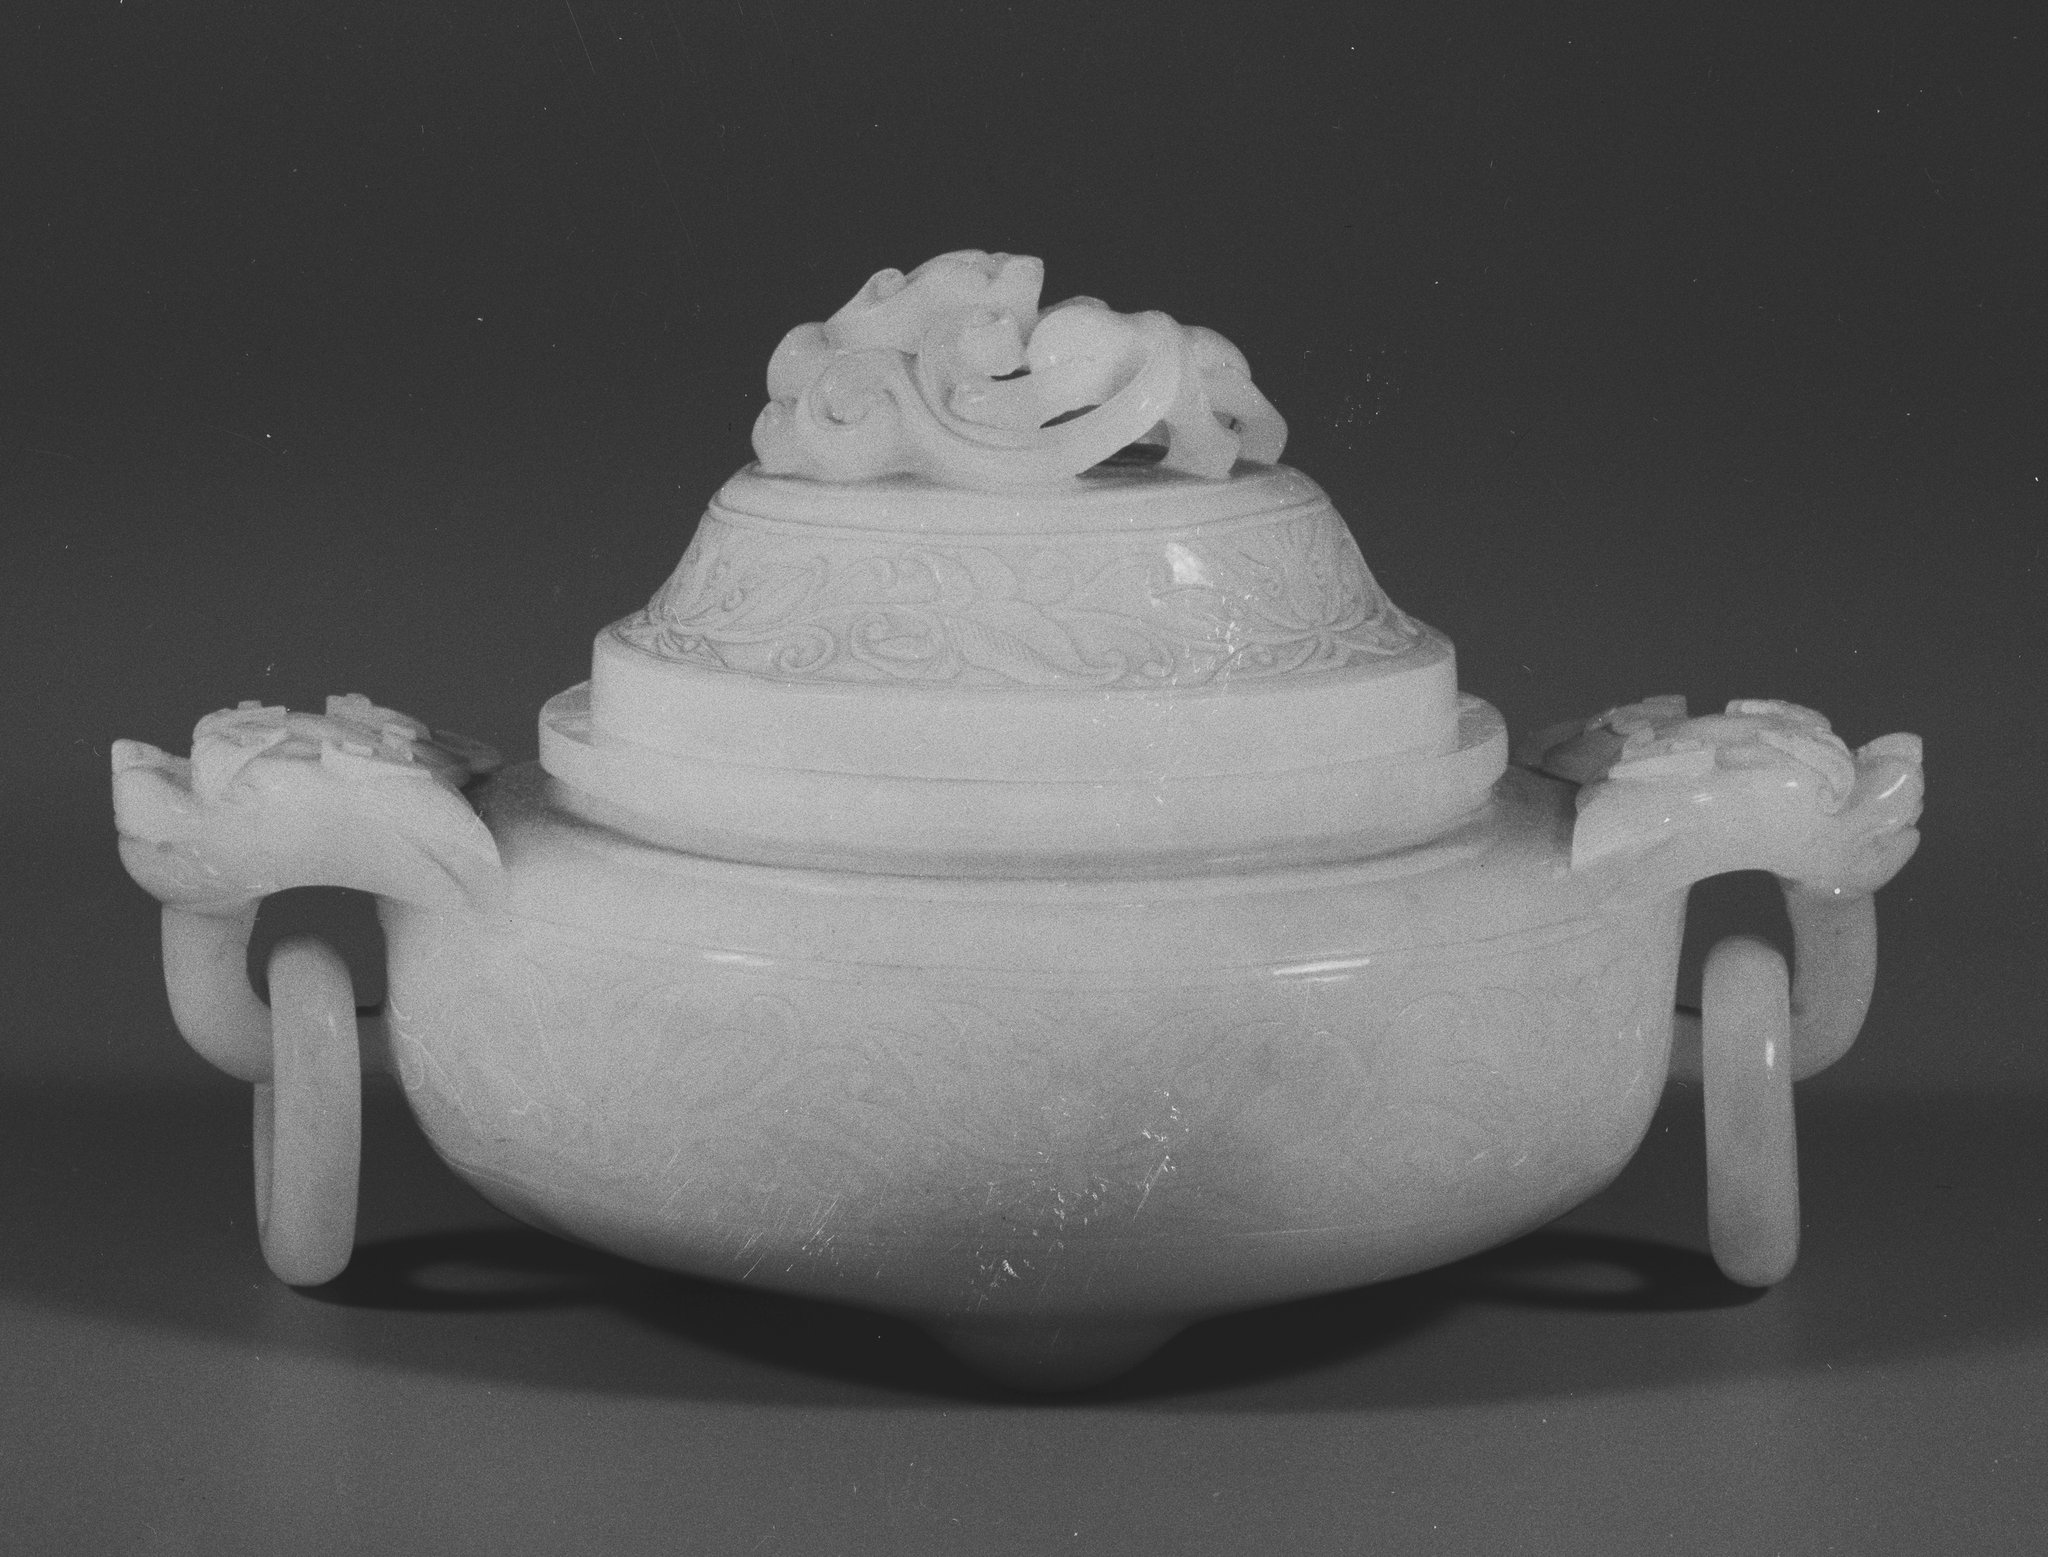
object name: incense burner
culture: chinese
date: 1701-1800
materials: jade